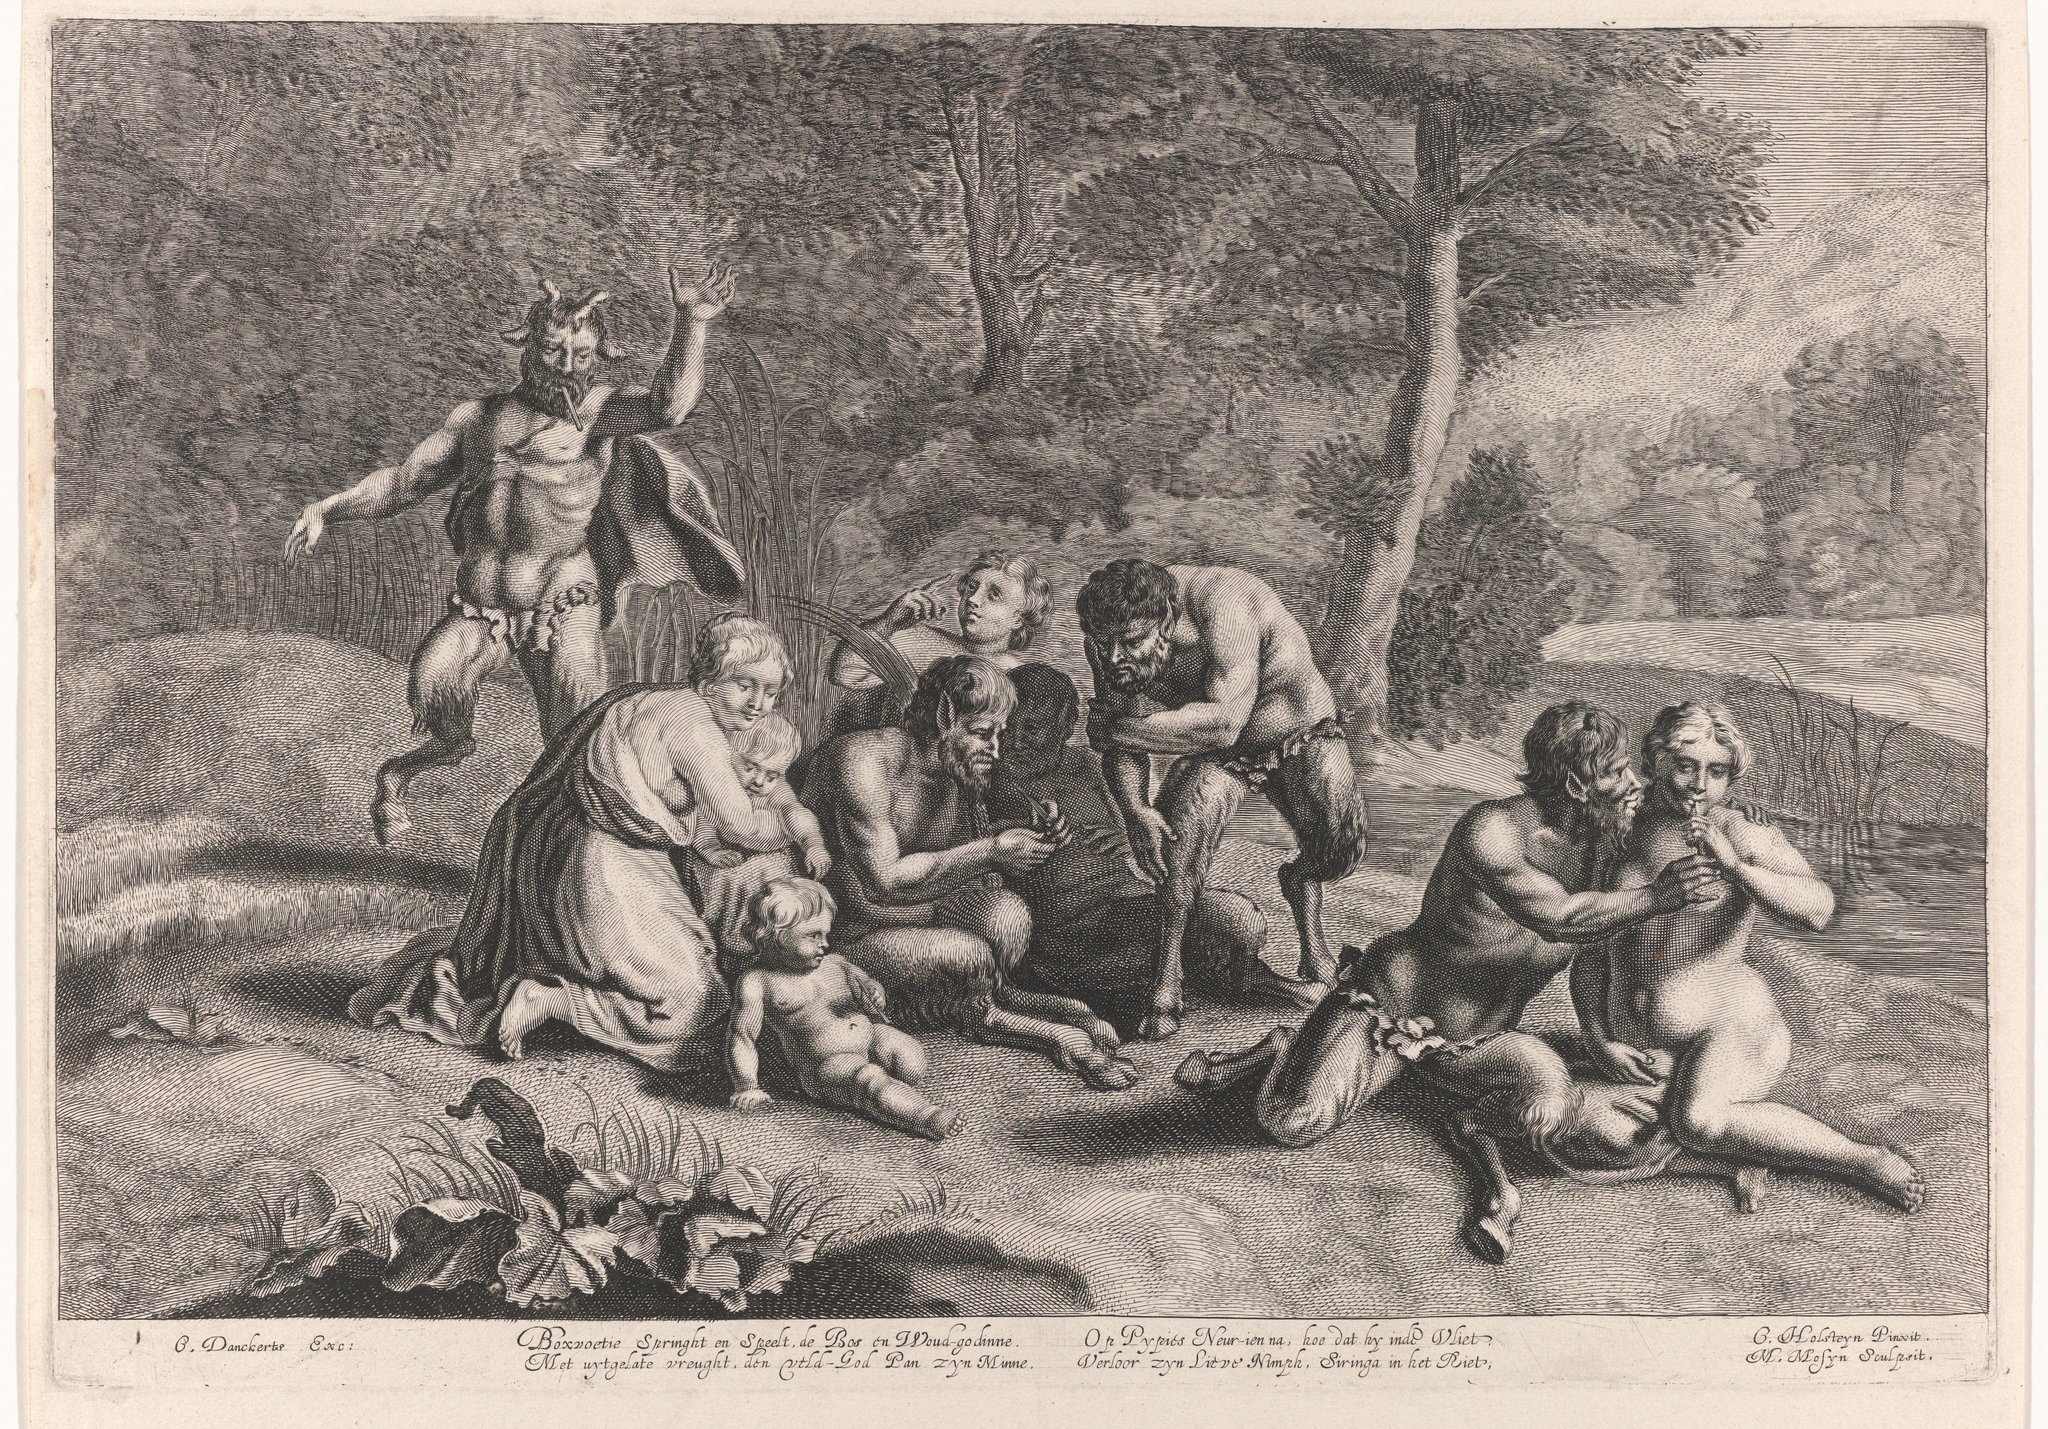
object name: print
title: Familie van saters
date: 1640-1655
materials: paper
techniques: engraving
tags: landscapes in the temperate zone, satyr(s) (in general), flute, aulos, tibia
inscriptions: collector's mark: Lugt 240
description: Een familie van saters zit bijeen. Een van de saters maakt te midden van vrouwen en kinderen een fluit, een andere sater kijkt aandachtig. Rechts een minnekozend paar, waarbij de sater de vrouw fluit leert spelen. Onderaan in de marge een vierregelig vers in het Nederlands.